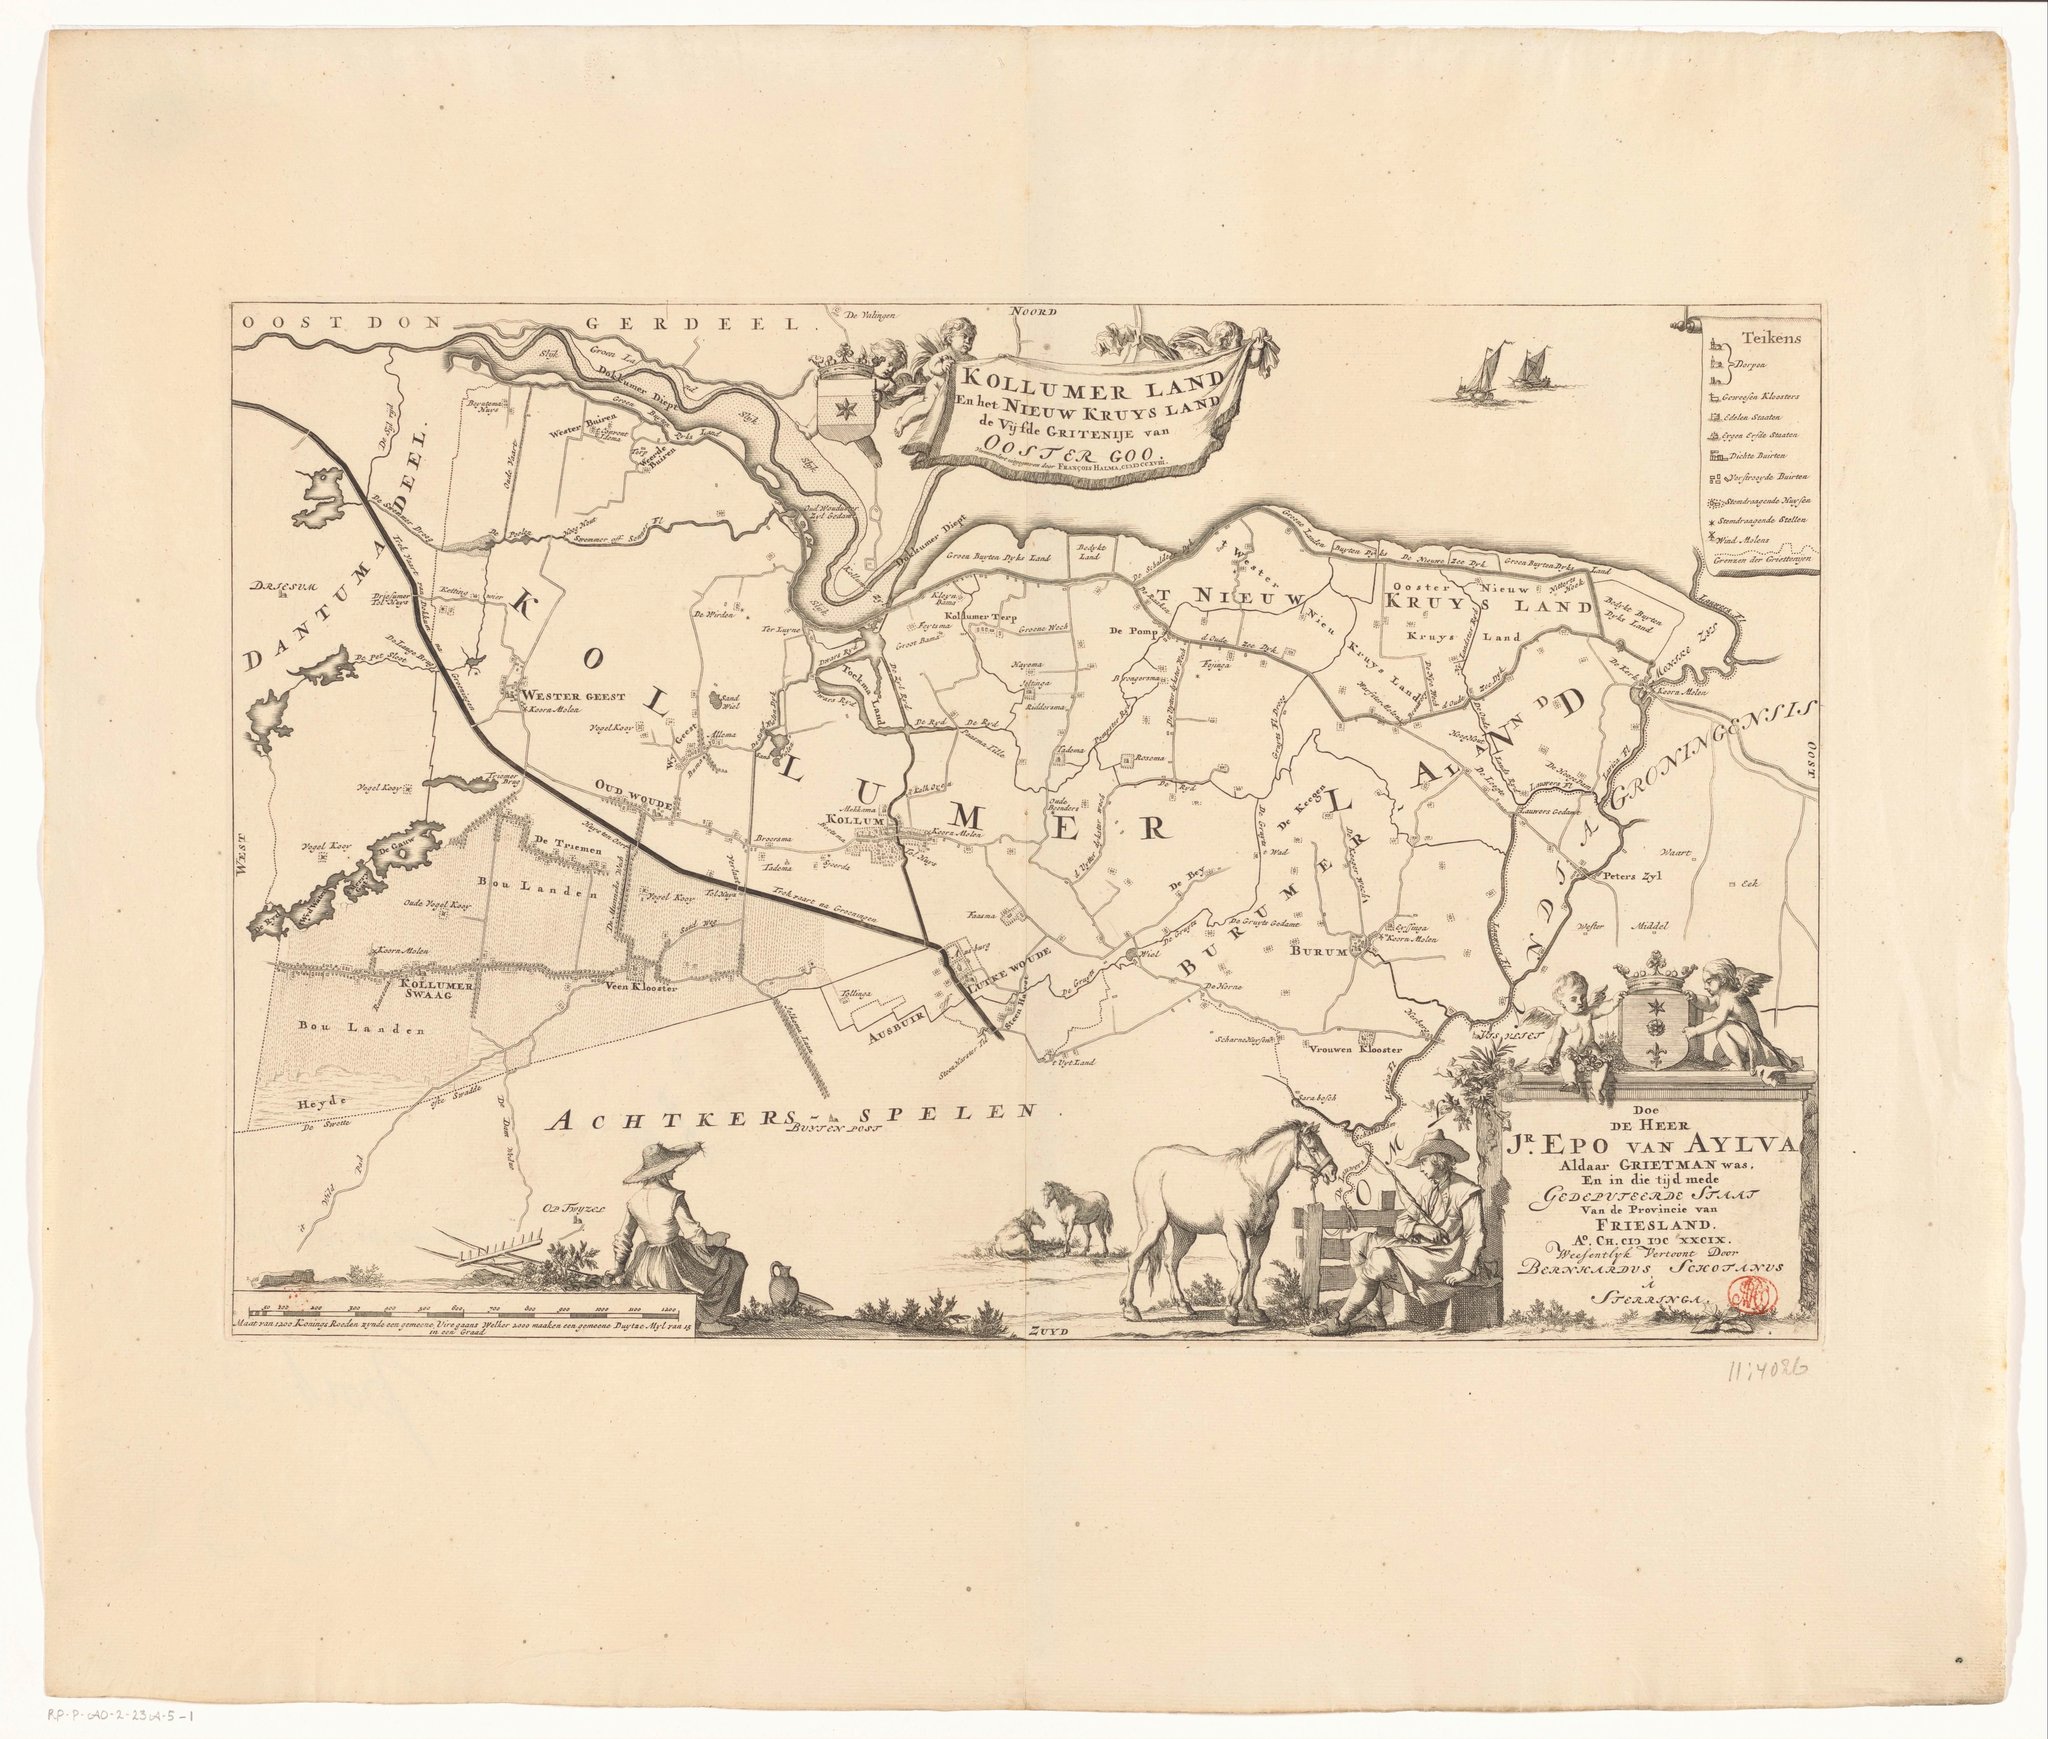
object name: map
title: Kaart van de grietenij Kollumerland en Nieuwkruisland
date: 1698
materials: paper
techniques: engraving, etching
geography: friesland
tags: coat of arms (as symbol of the state, etc.), maps of separate countries or regions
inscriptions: collector's mark: Lugt 195, label: ‘264’, collector's mark: Lugt 2228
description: Boven in het midden titelcartouche met daarnaast het wapen van Kollumerland en Nieuwkruisland. Rechtsboven legenda. Rechtsonder cartouche met bestuurlijke informatie over de grietenij, daarboven het wapen van grietman jonker Epo van Aylva. Linksonder een schaalstok: Maat van 1200 konings roeden zynde een gemeene uire gaans welker 2000 maaken een gemeene Duytze myl van 15 in een graad.